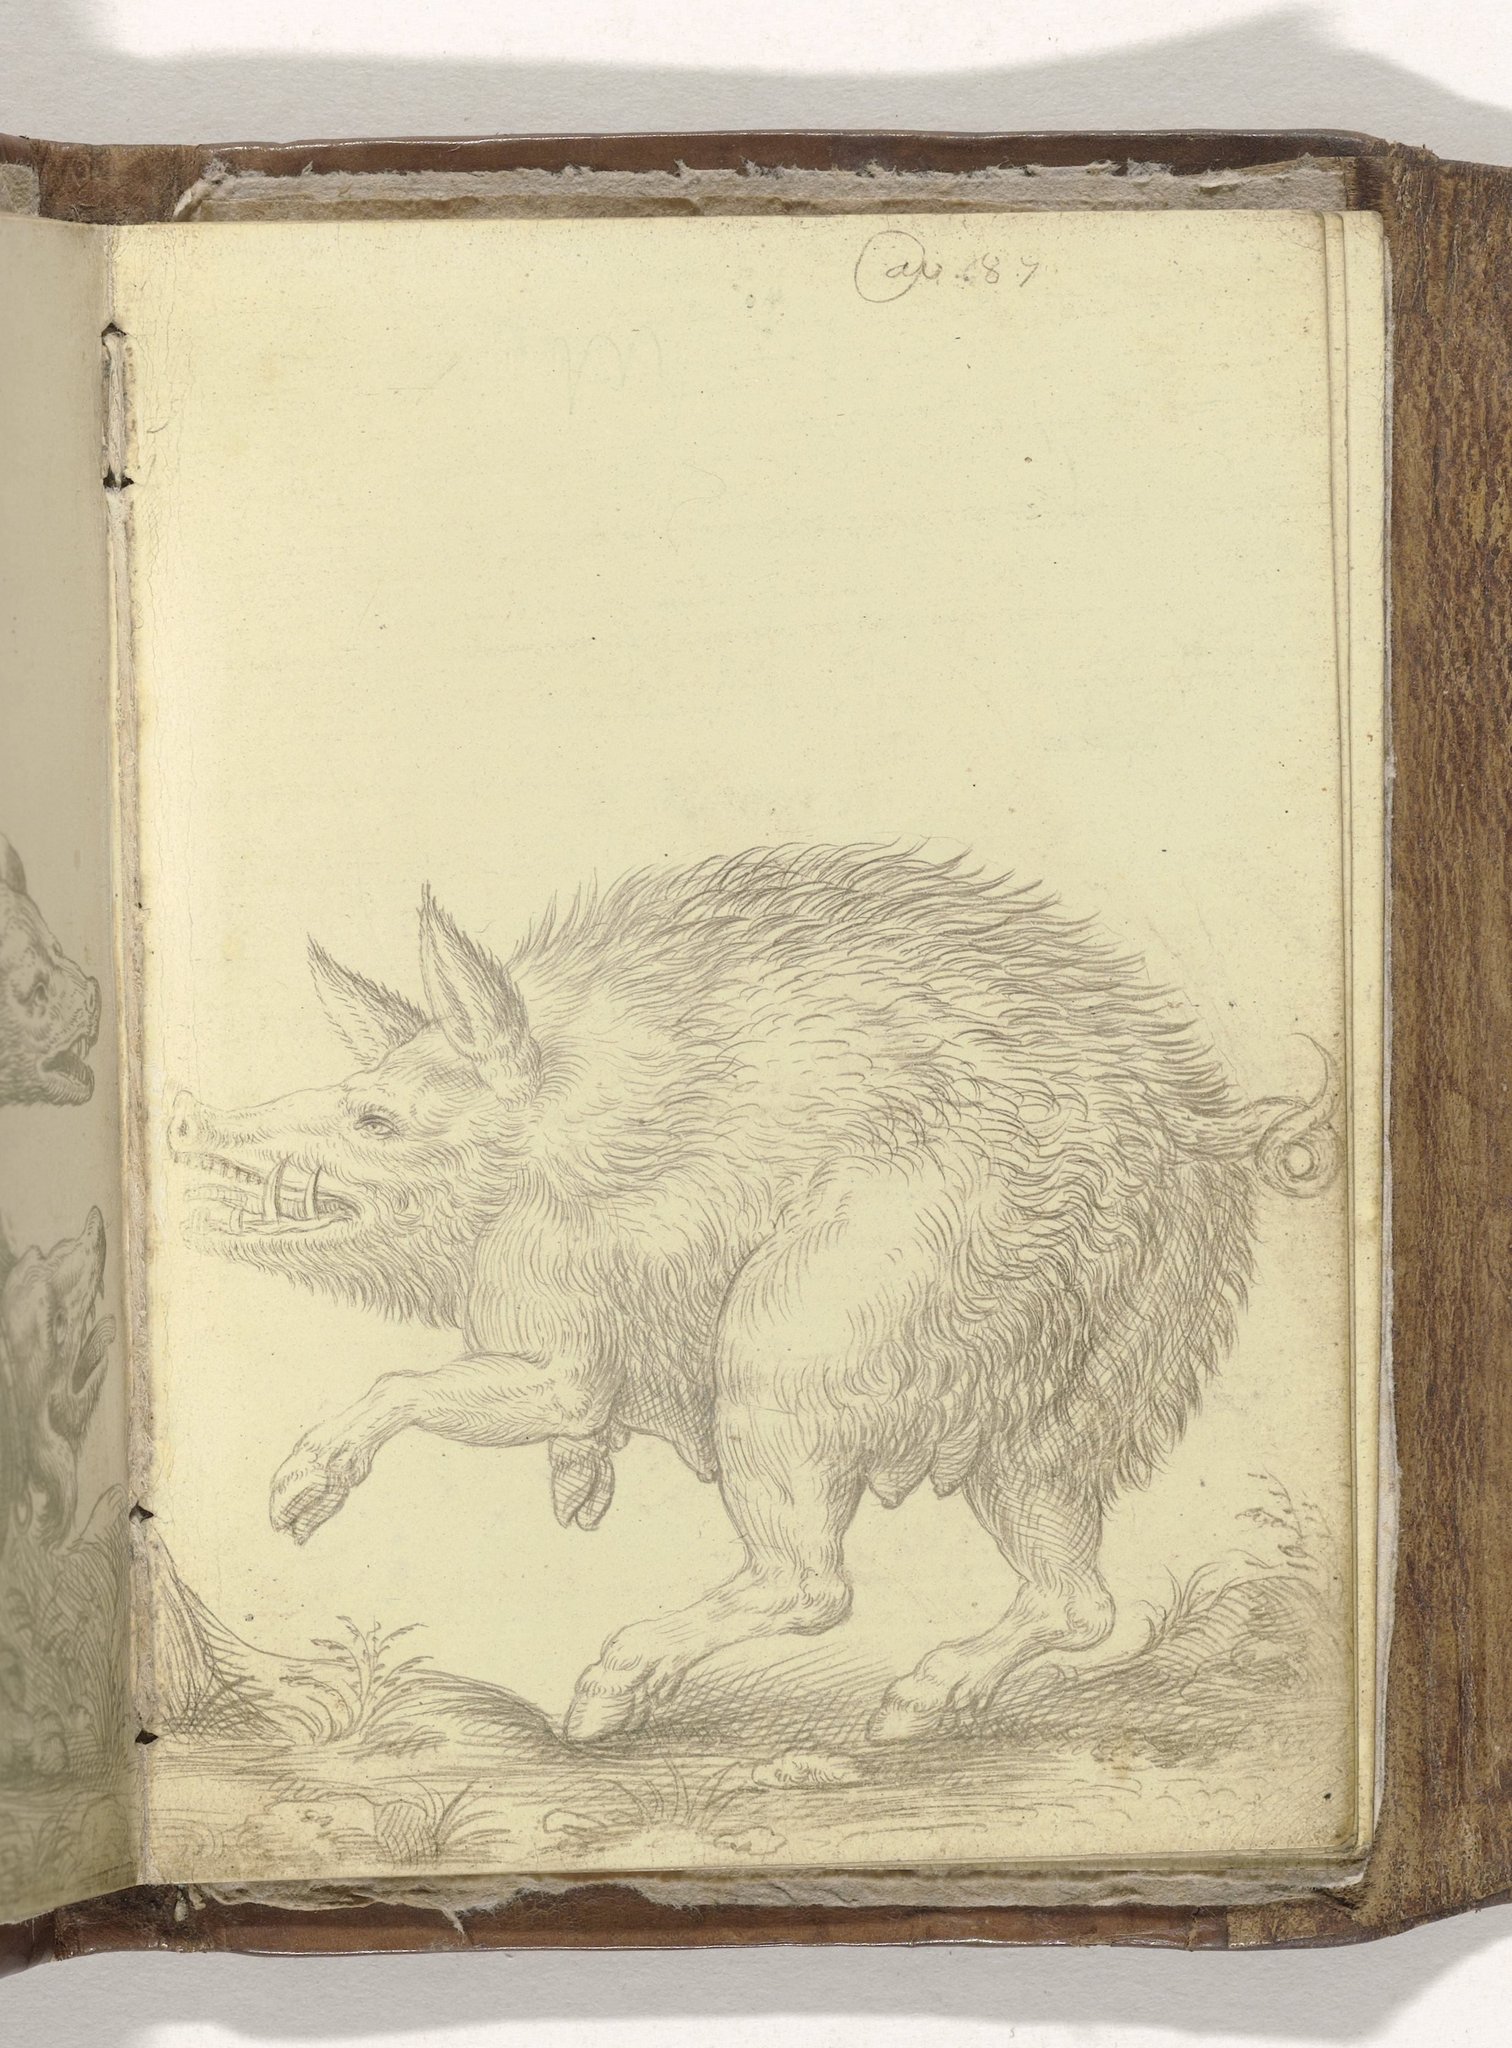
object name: drawing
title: Schetsboek "A.S.Fe", 1587, blad 8r(12)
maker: Anonymous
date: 1587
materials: paper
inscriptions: date